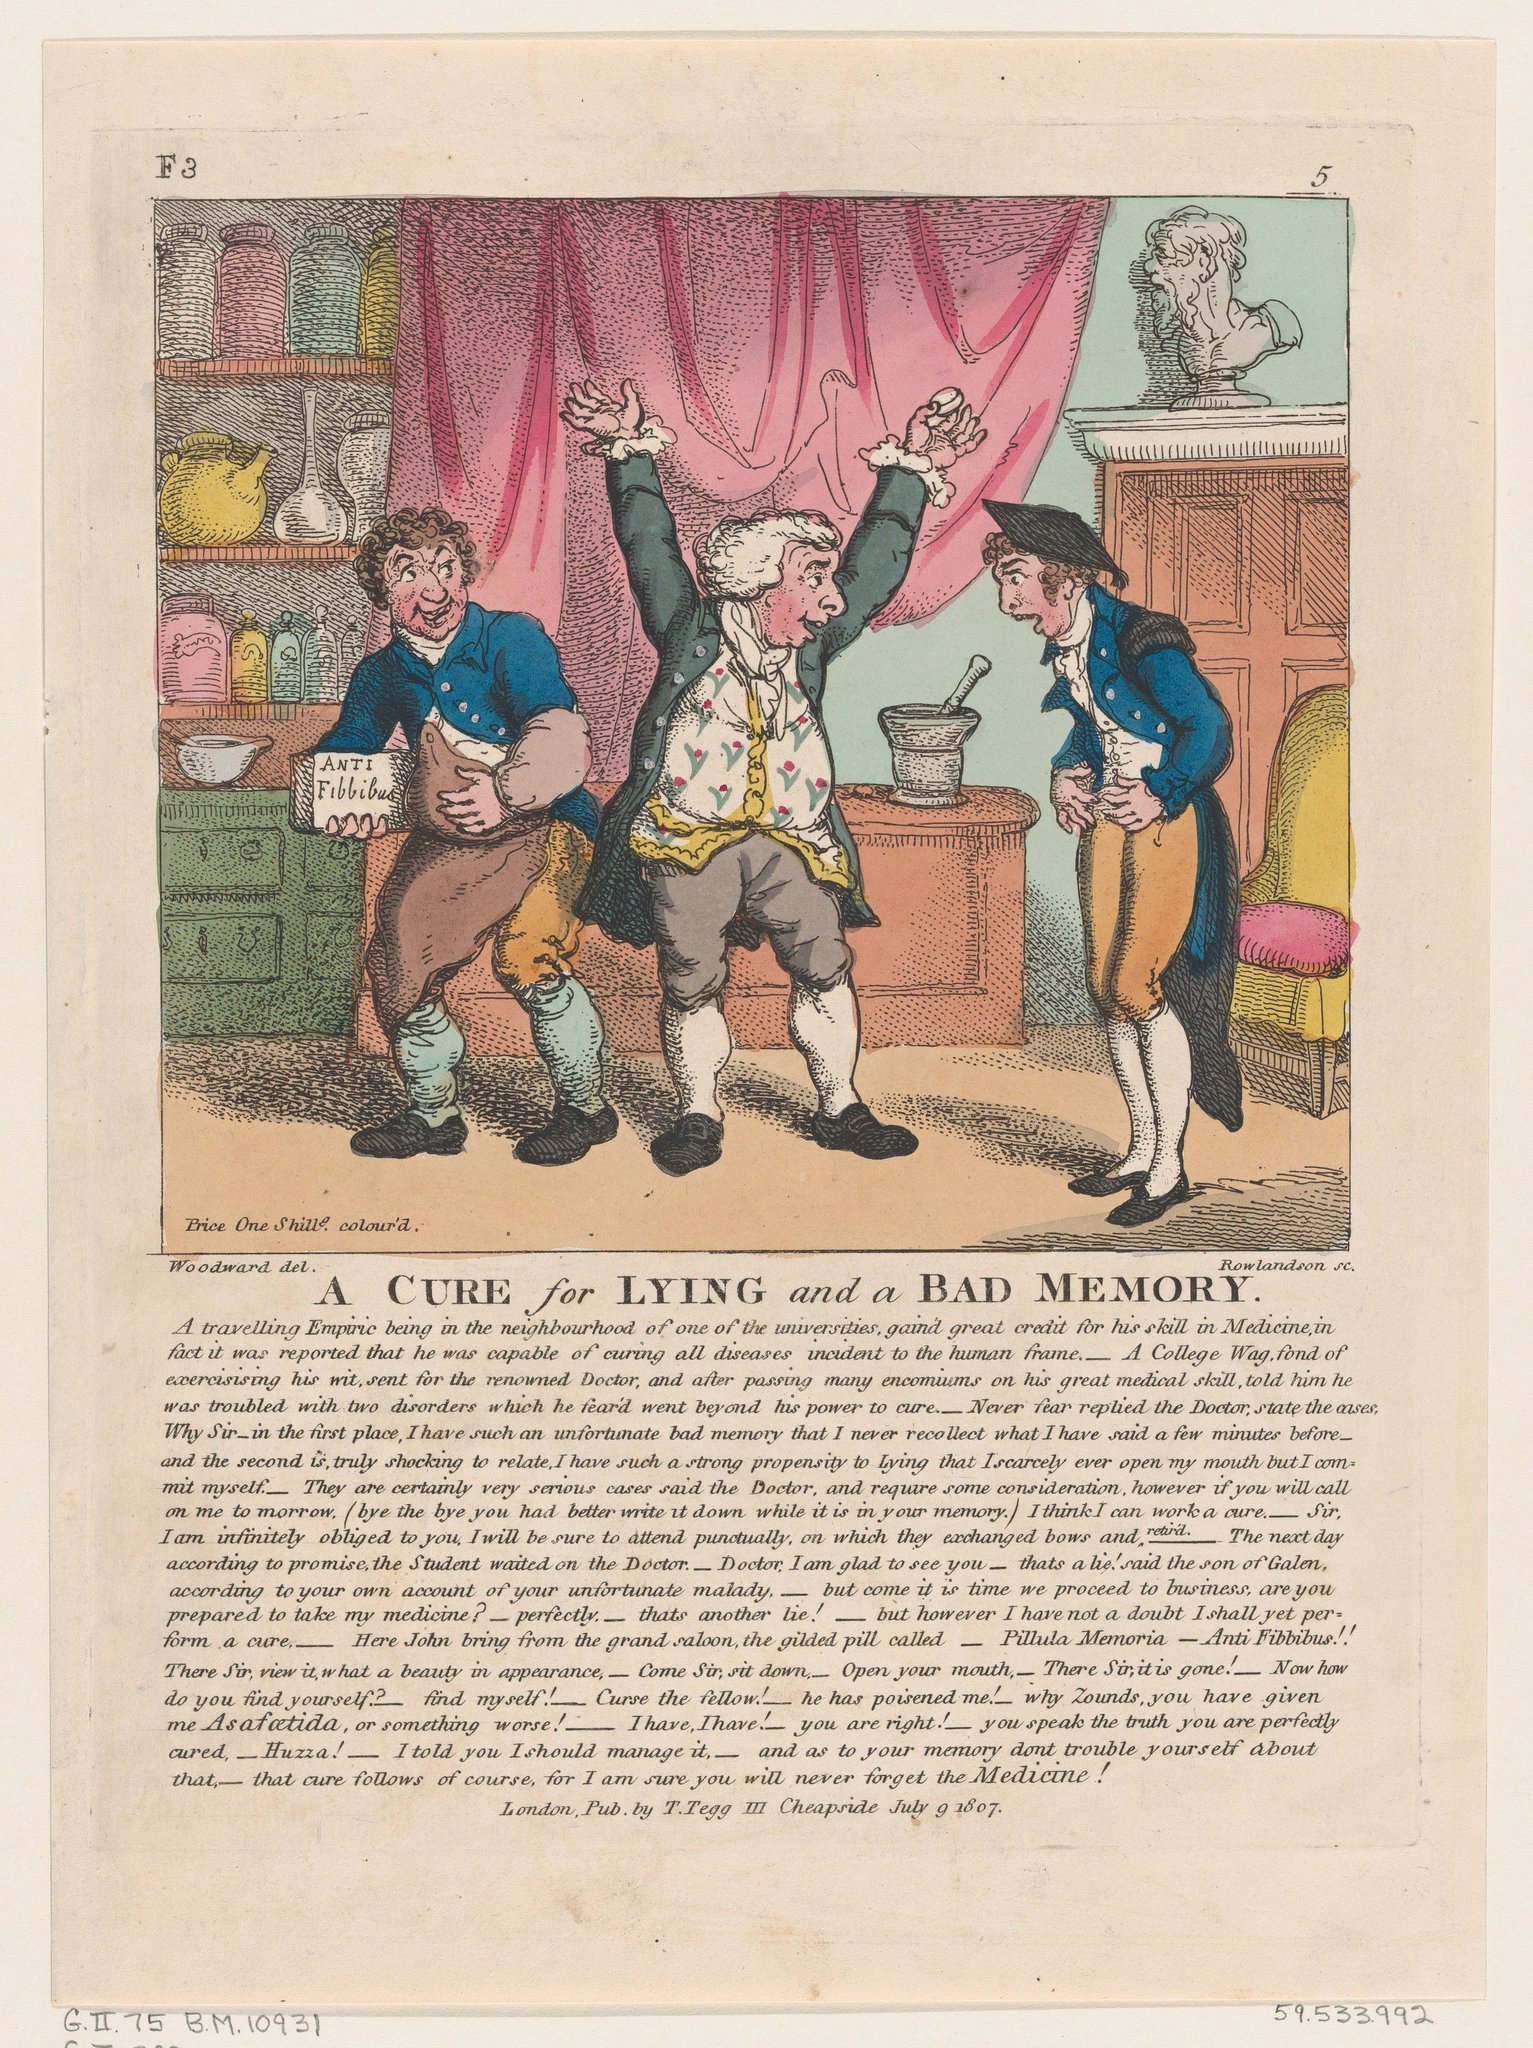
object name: print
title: A Cure for Lying and a Bad Memory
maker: thomas rowlandson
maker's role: artist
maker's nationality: british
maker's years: 1757-1827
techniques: etching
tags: satire,men